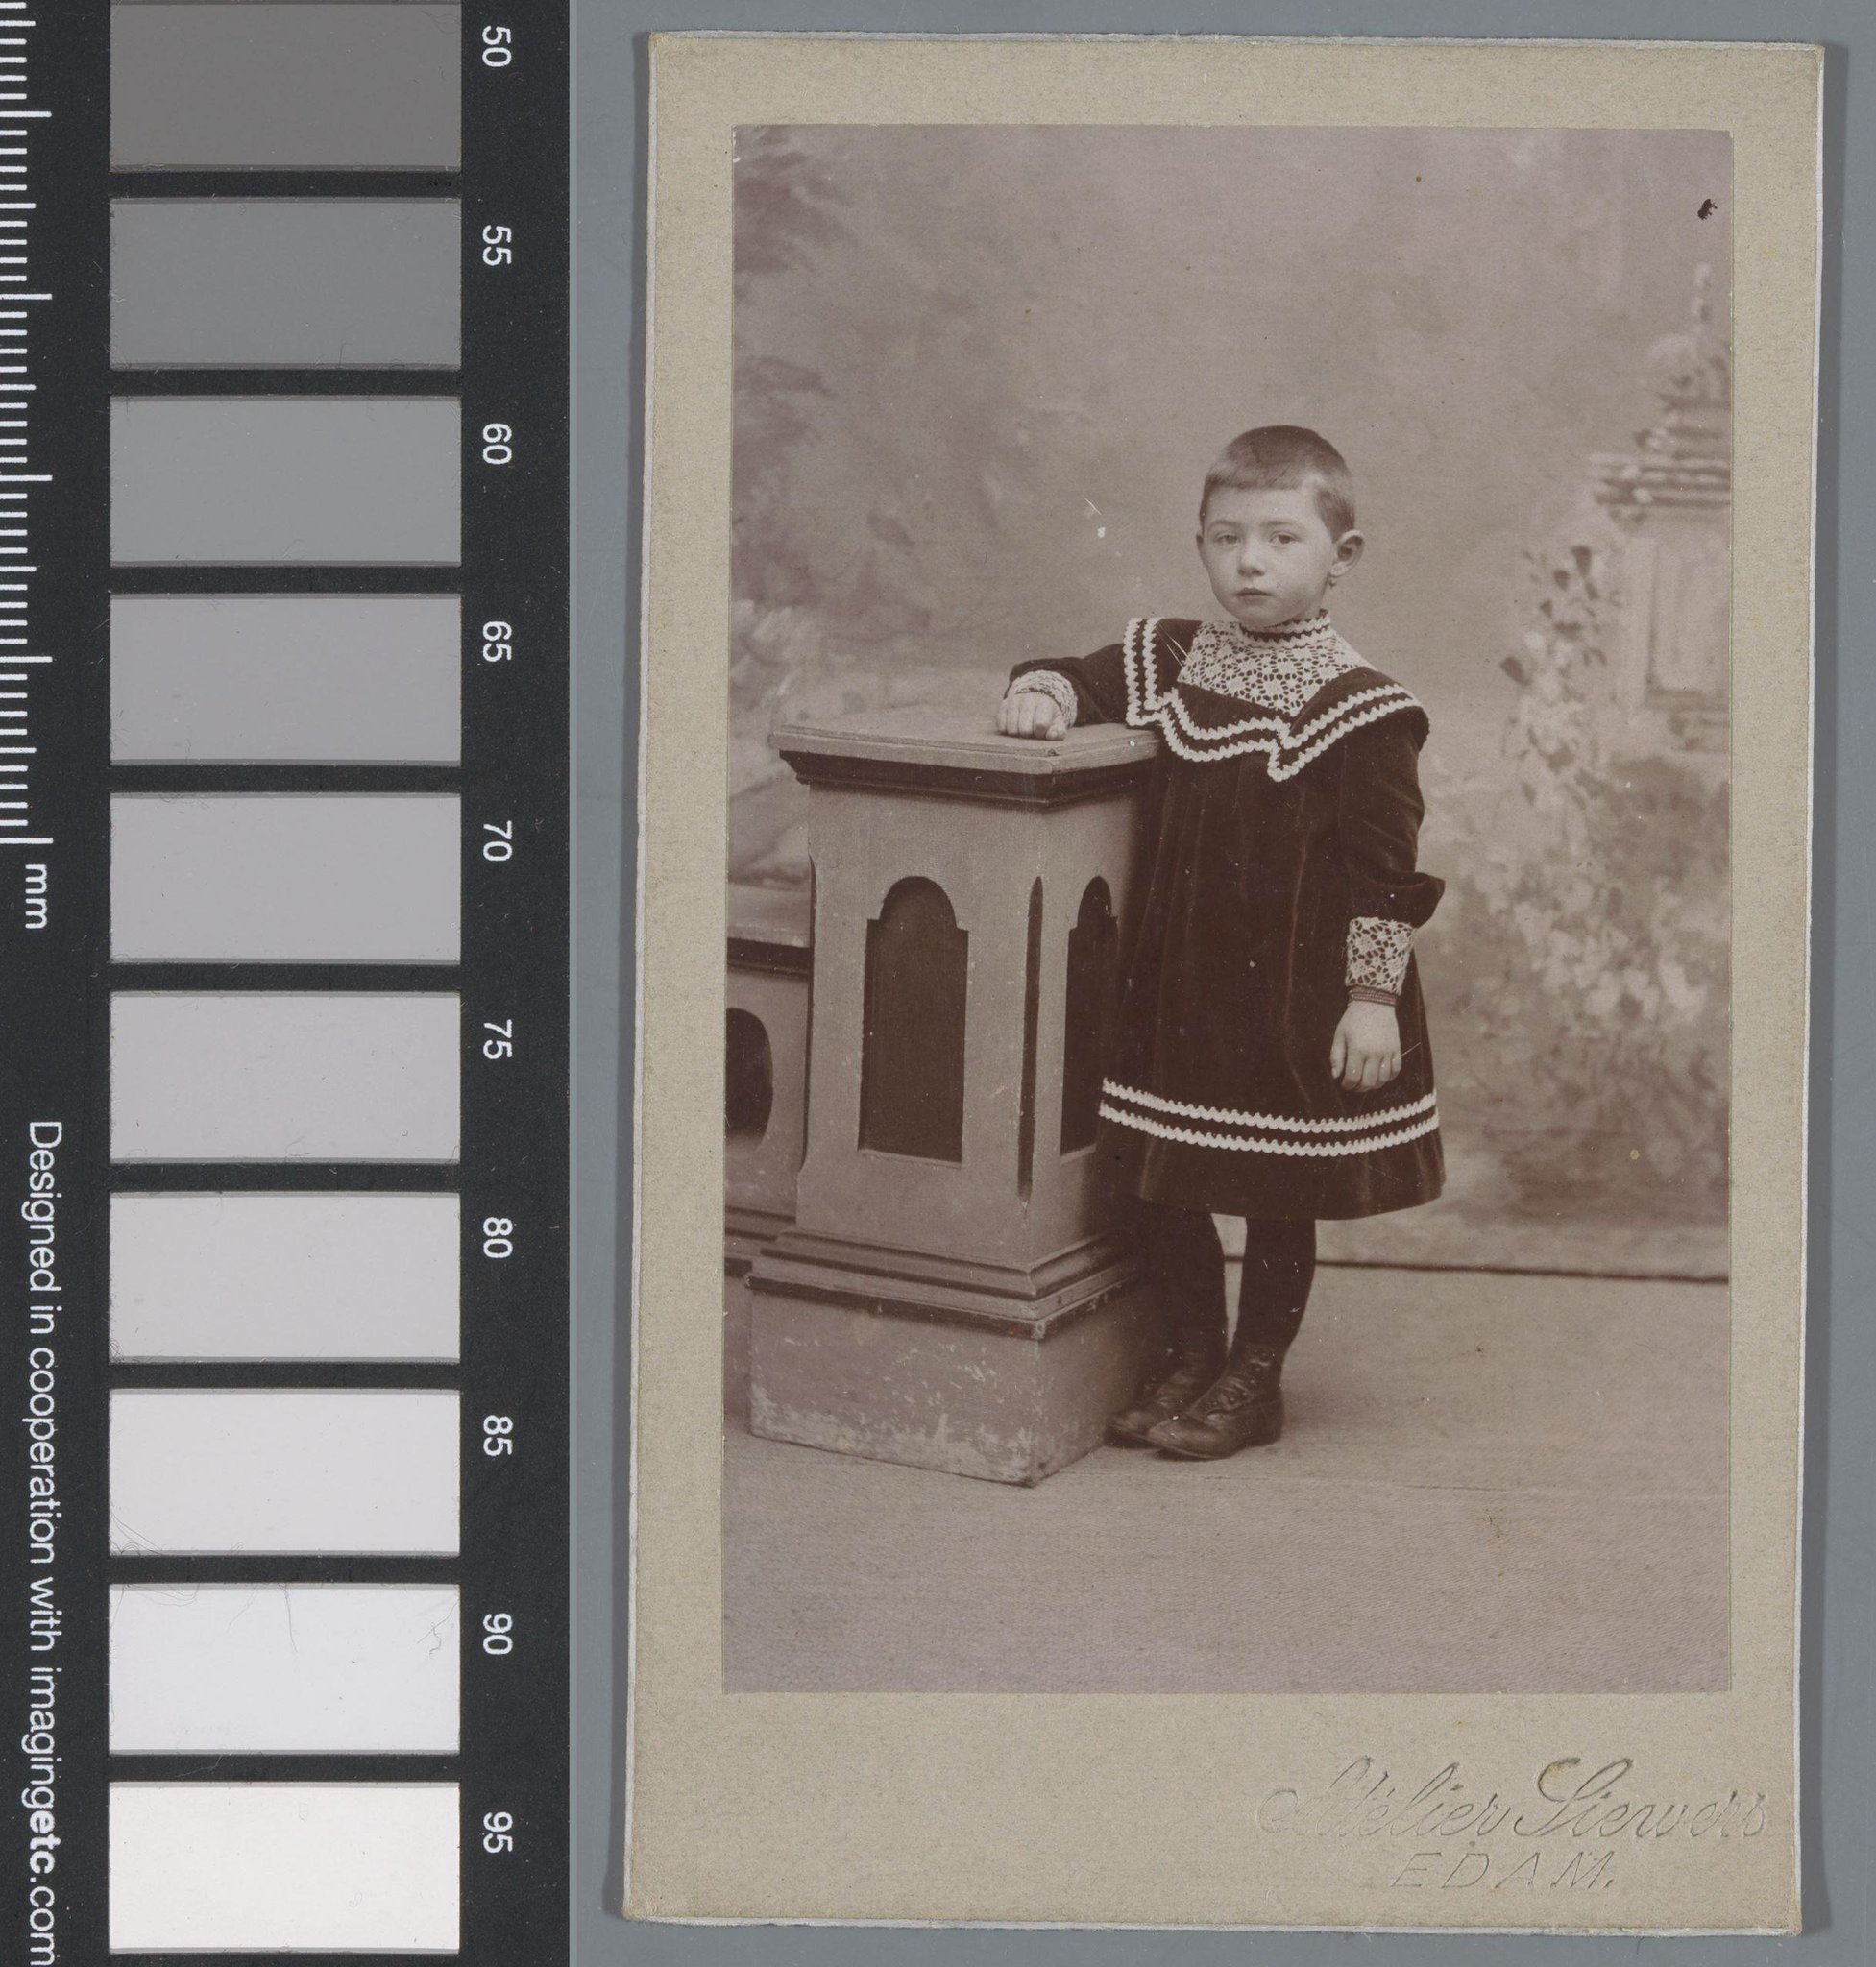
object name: carte de visite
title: Portret van Hiltje Buurs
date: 1890-1898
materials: paper, cardboard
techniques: gelatin silver print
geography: edam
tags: historical persons, girl (child between toddler and youth)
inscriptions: inscription: ‘EDAM’